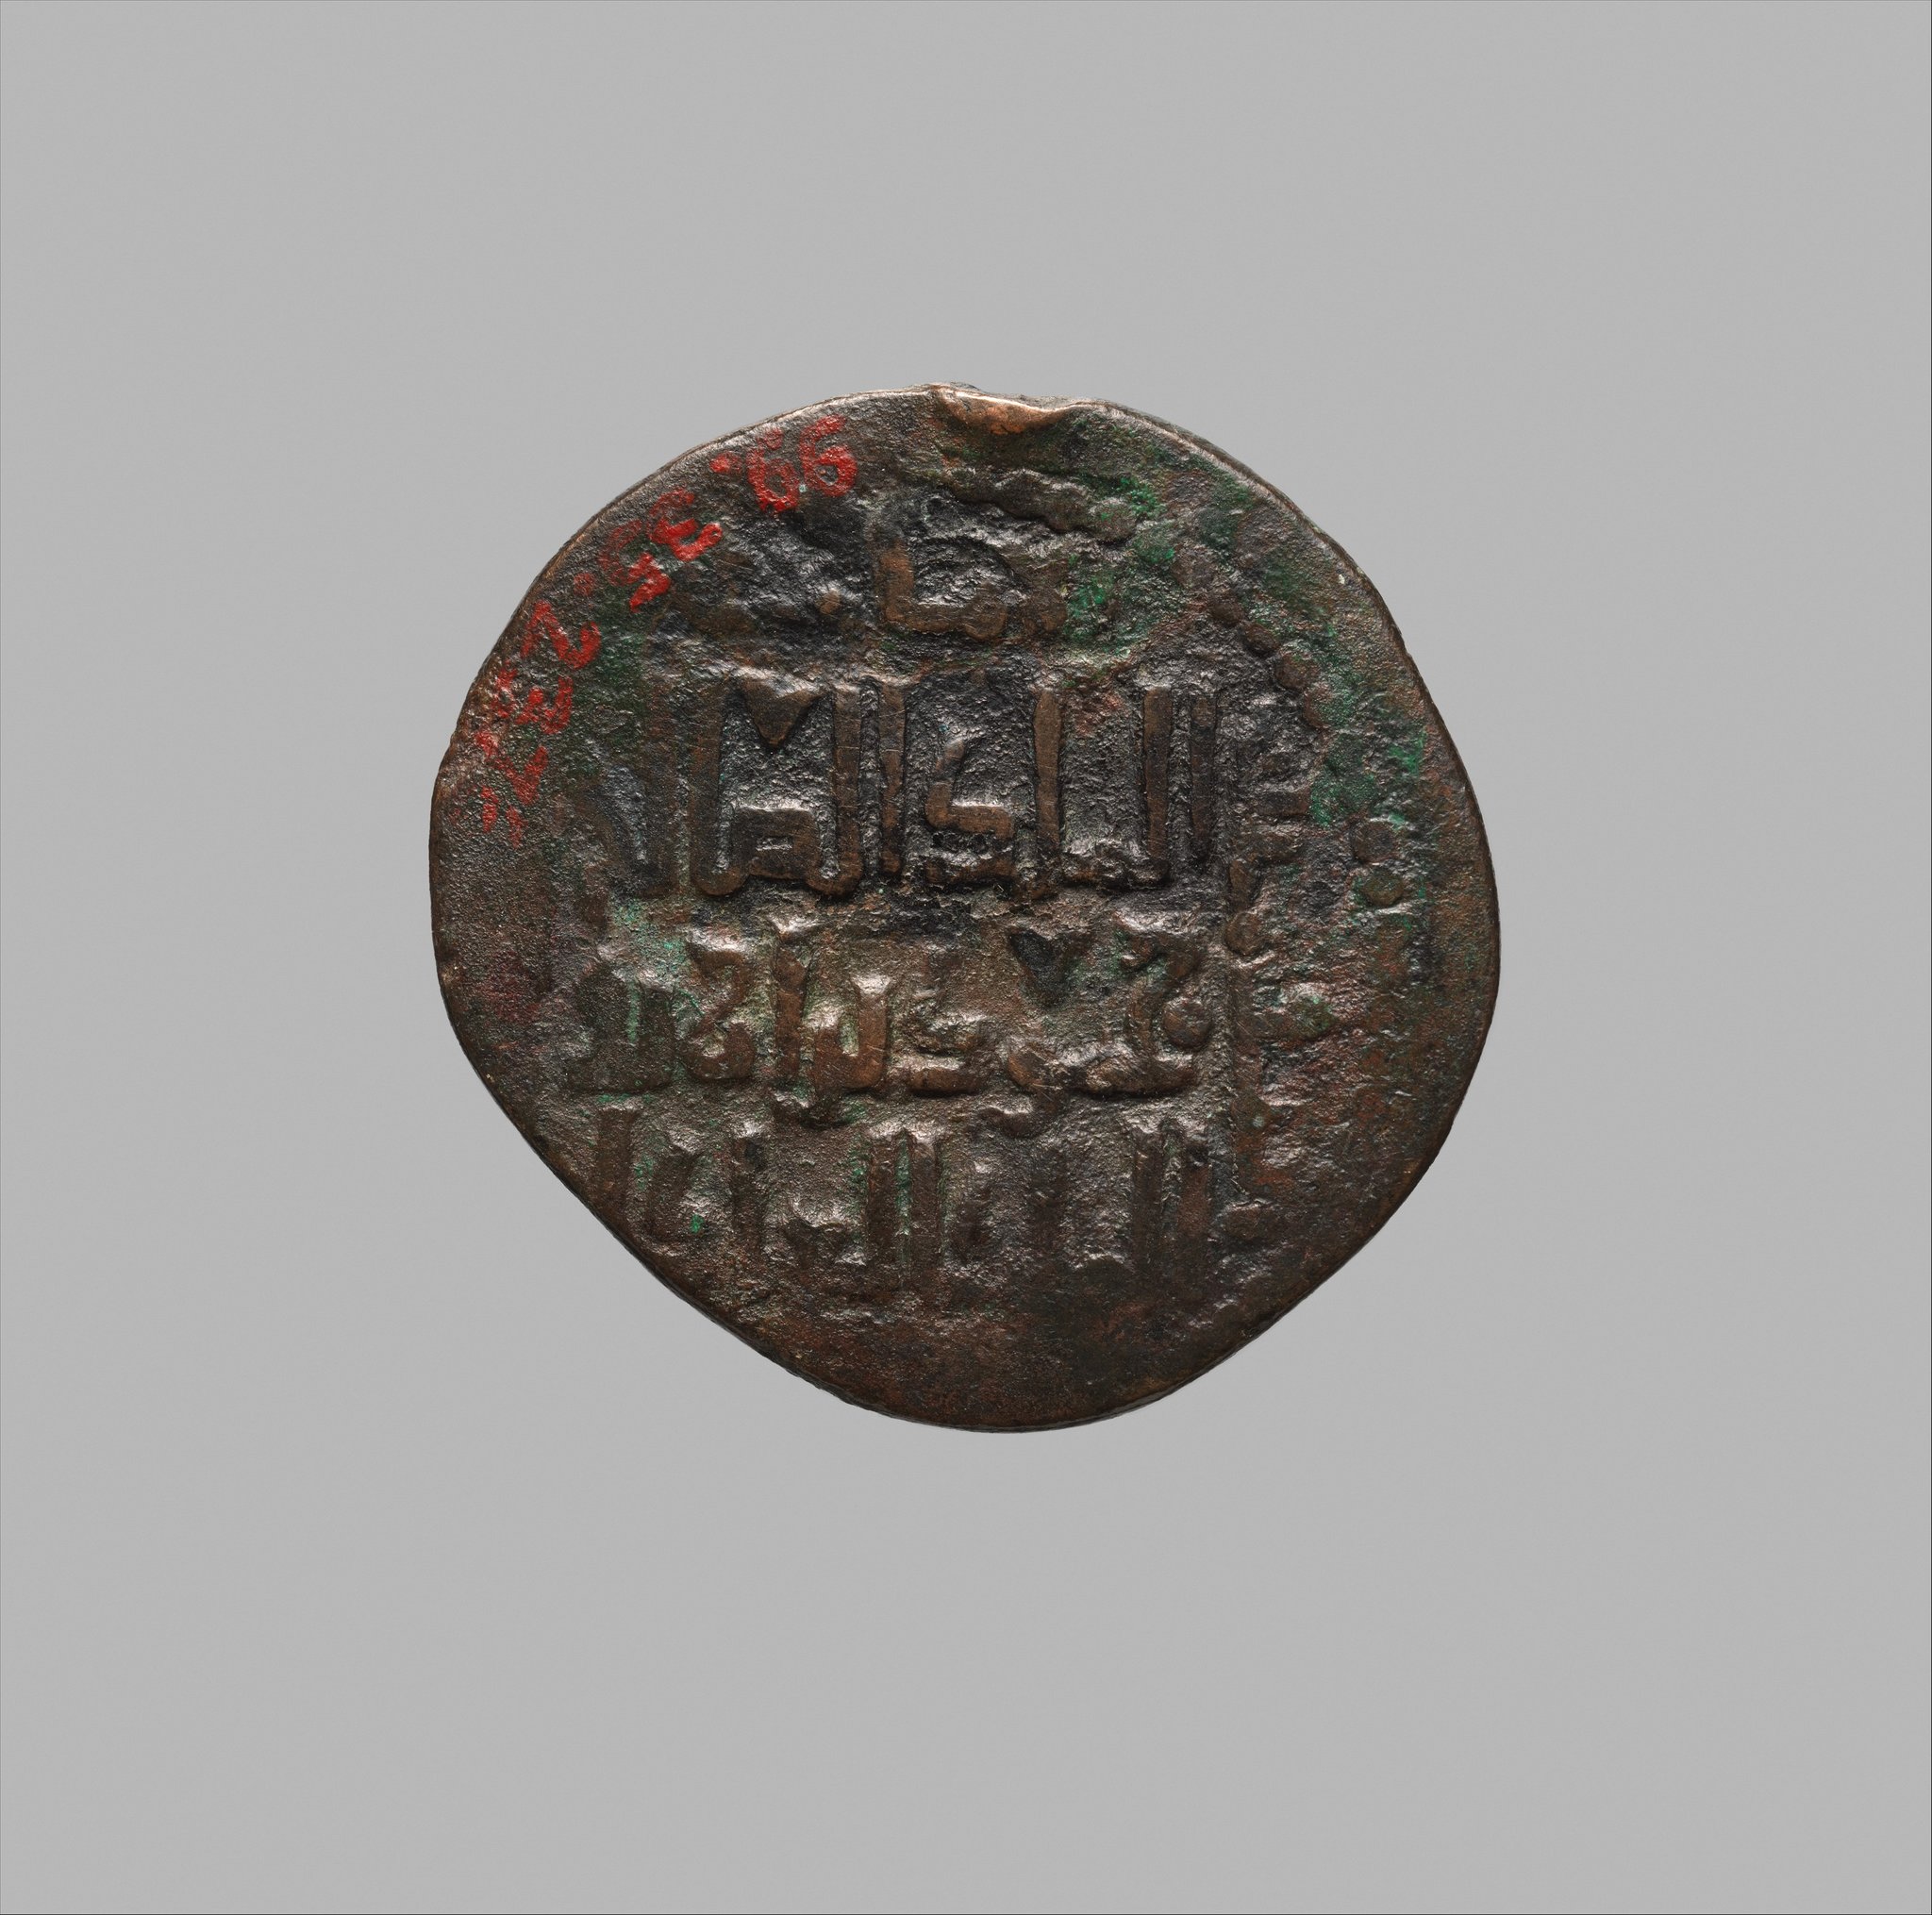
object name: coin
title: Dirham of Nasir al-Din Mahmud (r. 1201–22): Double-Headed Bird of Prey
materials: copper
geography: turkey